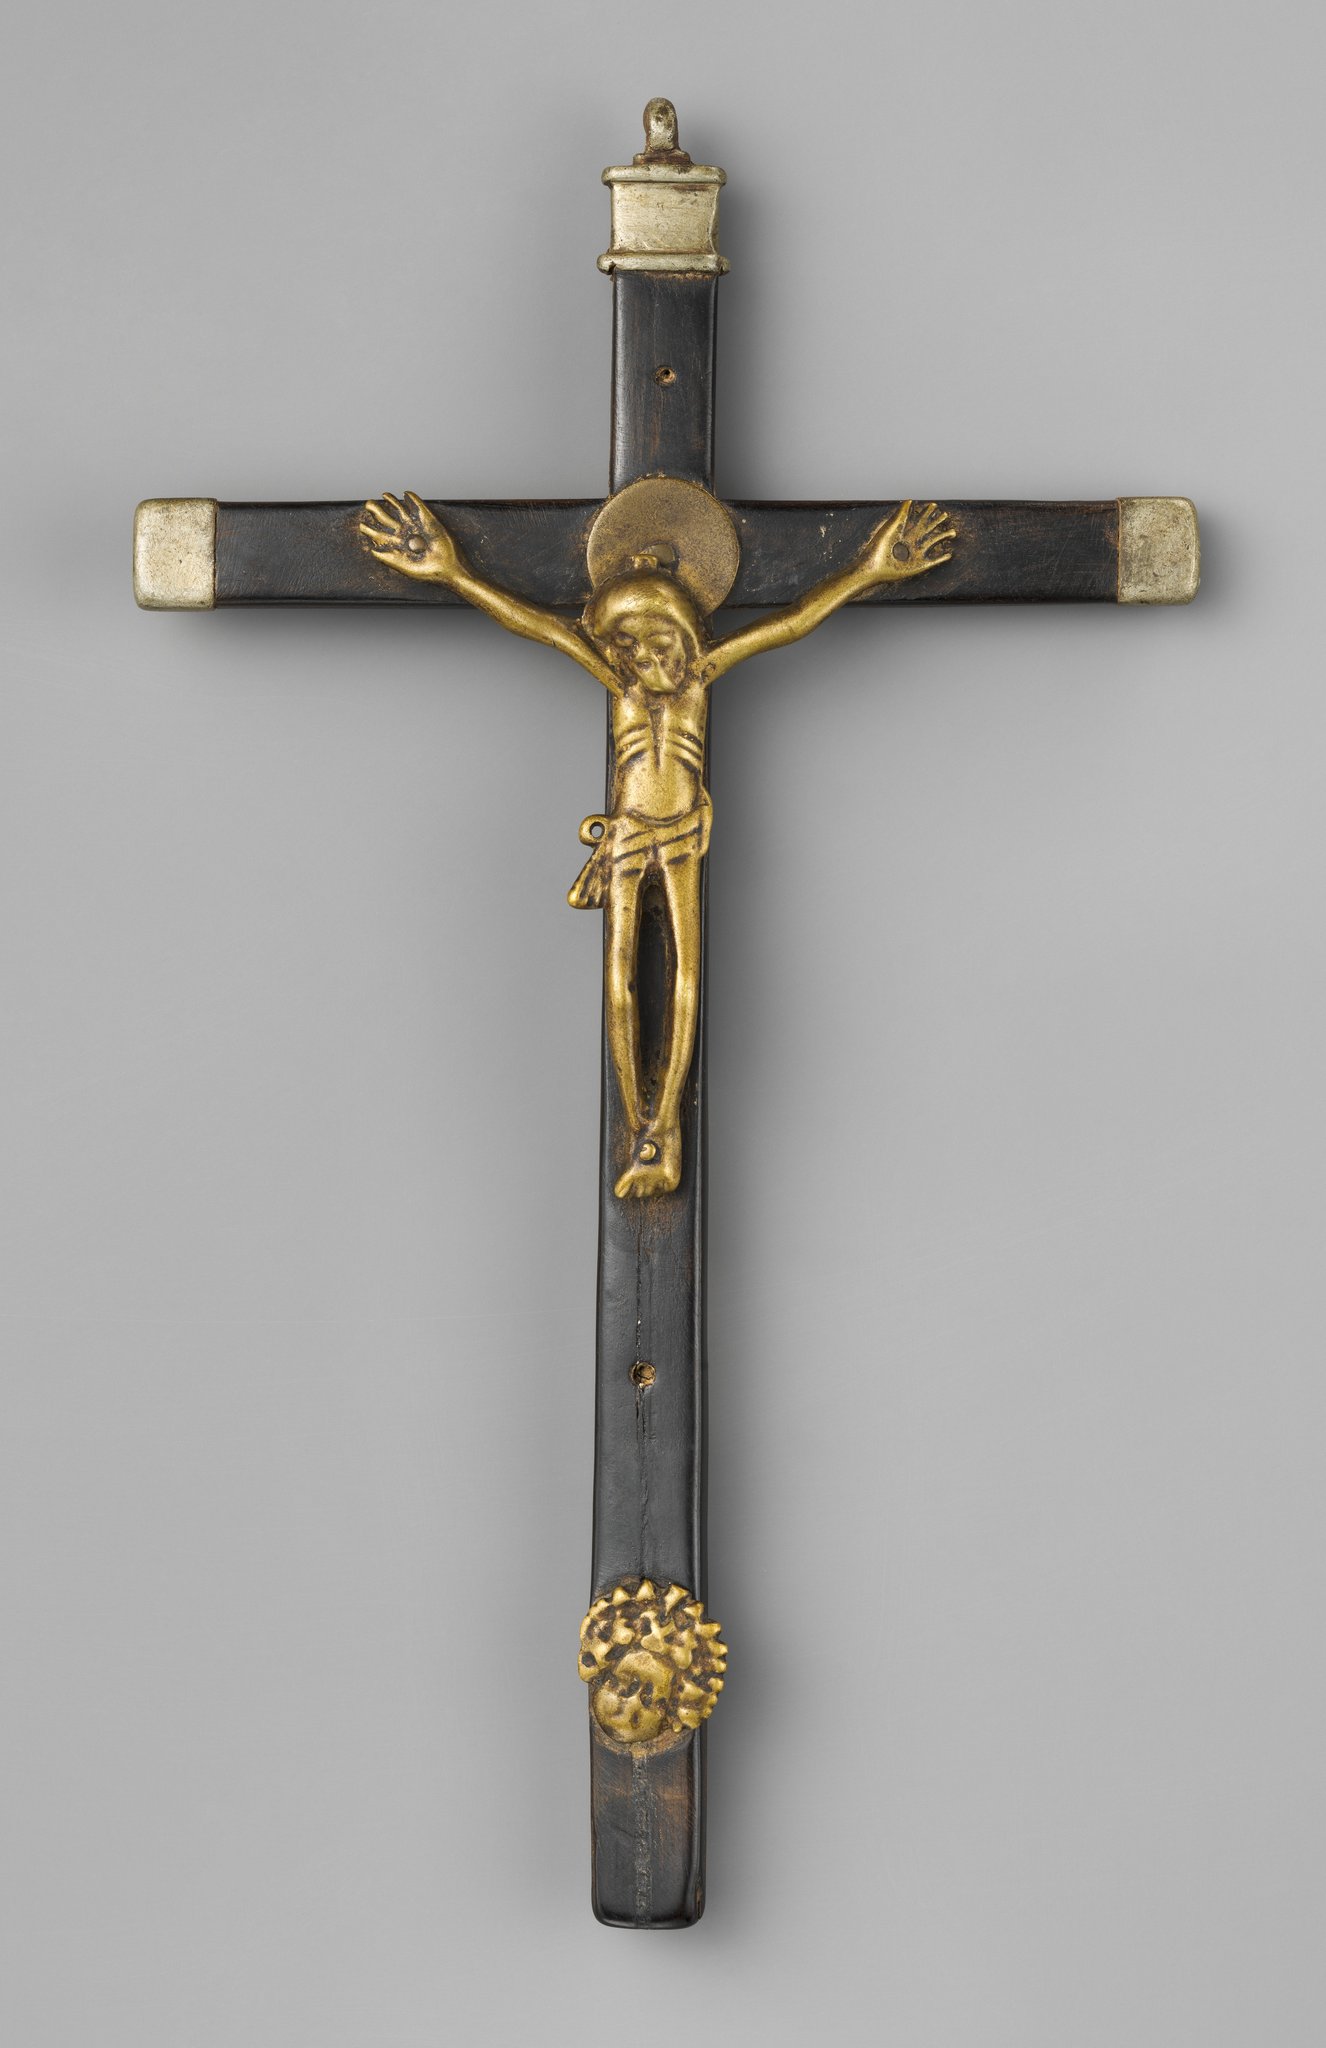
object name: crucifix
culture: kongo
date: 1701-1900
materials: brass, wood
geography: angola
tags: christ,cross,crucifixion